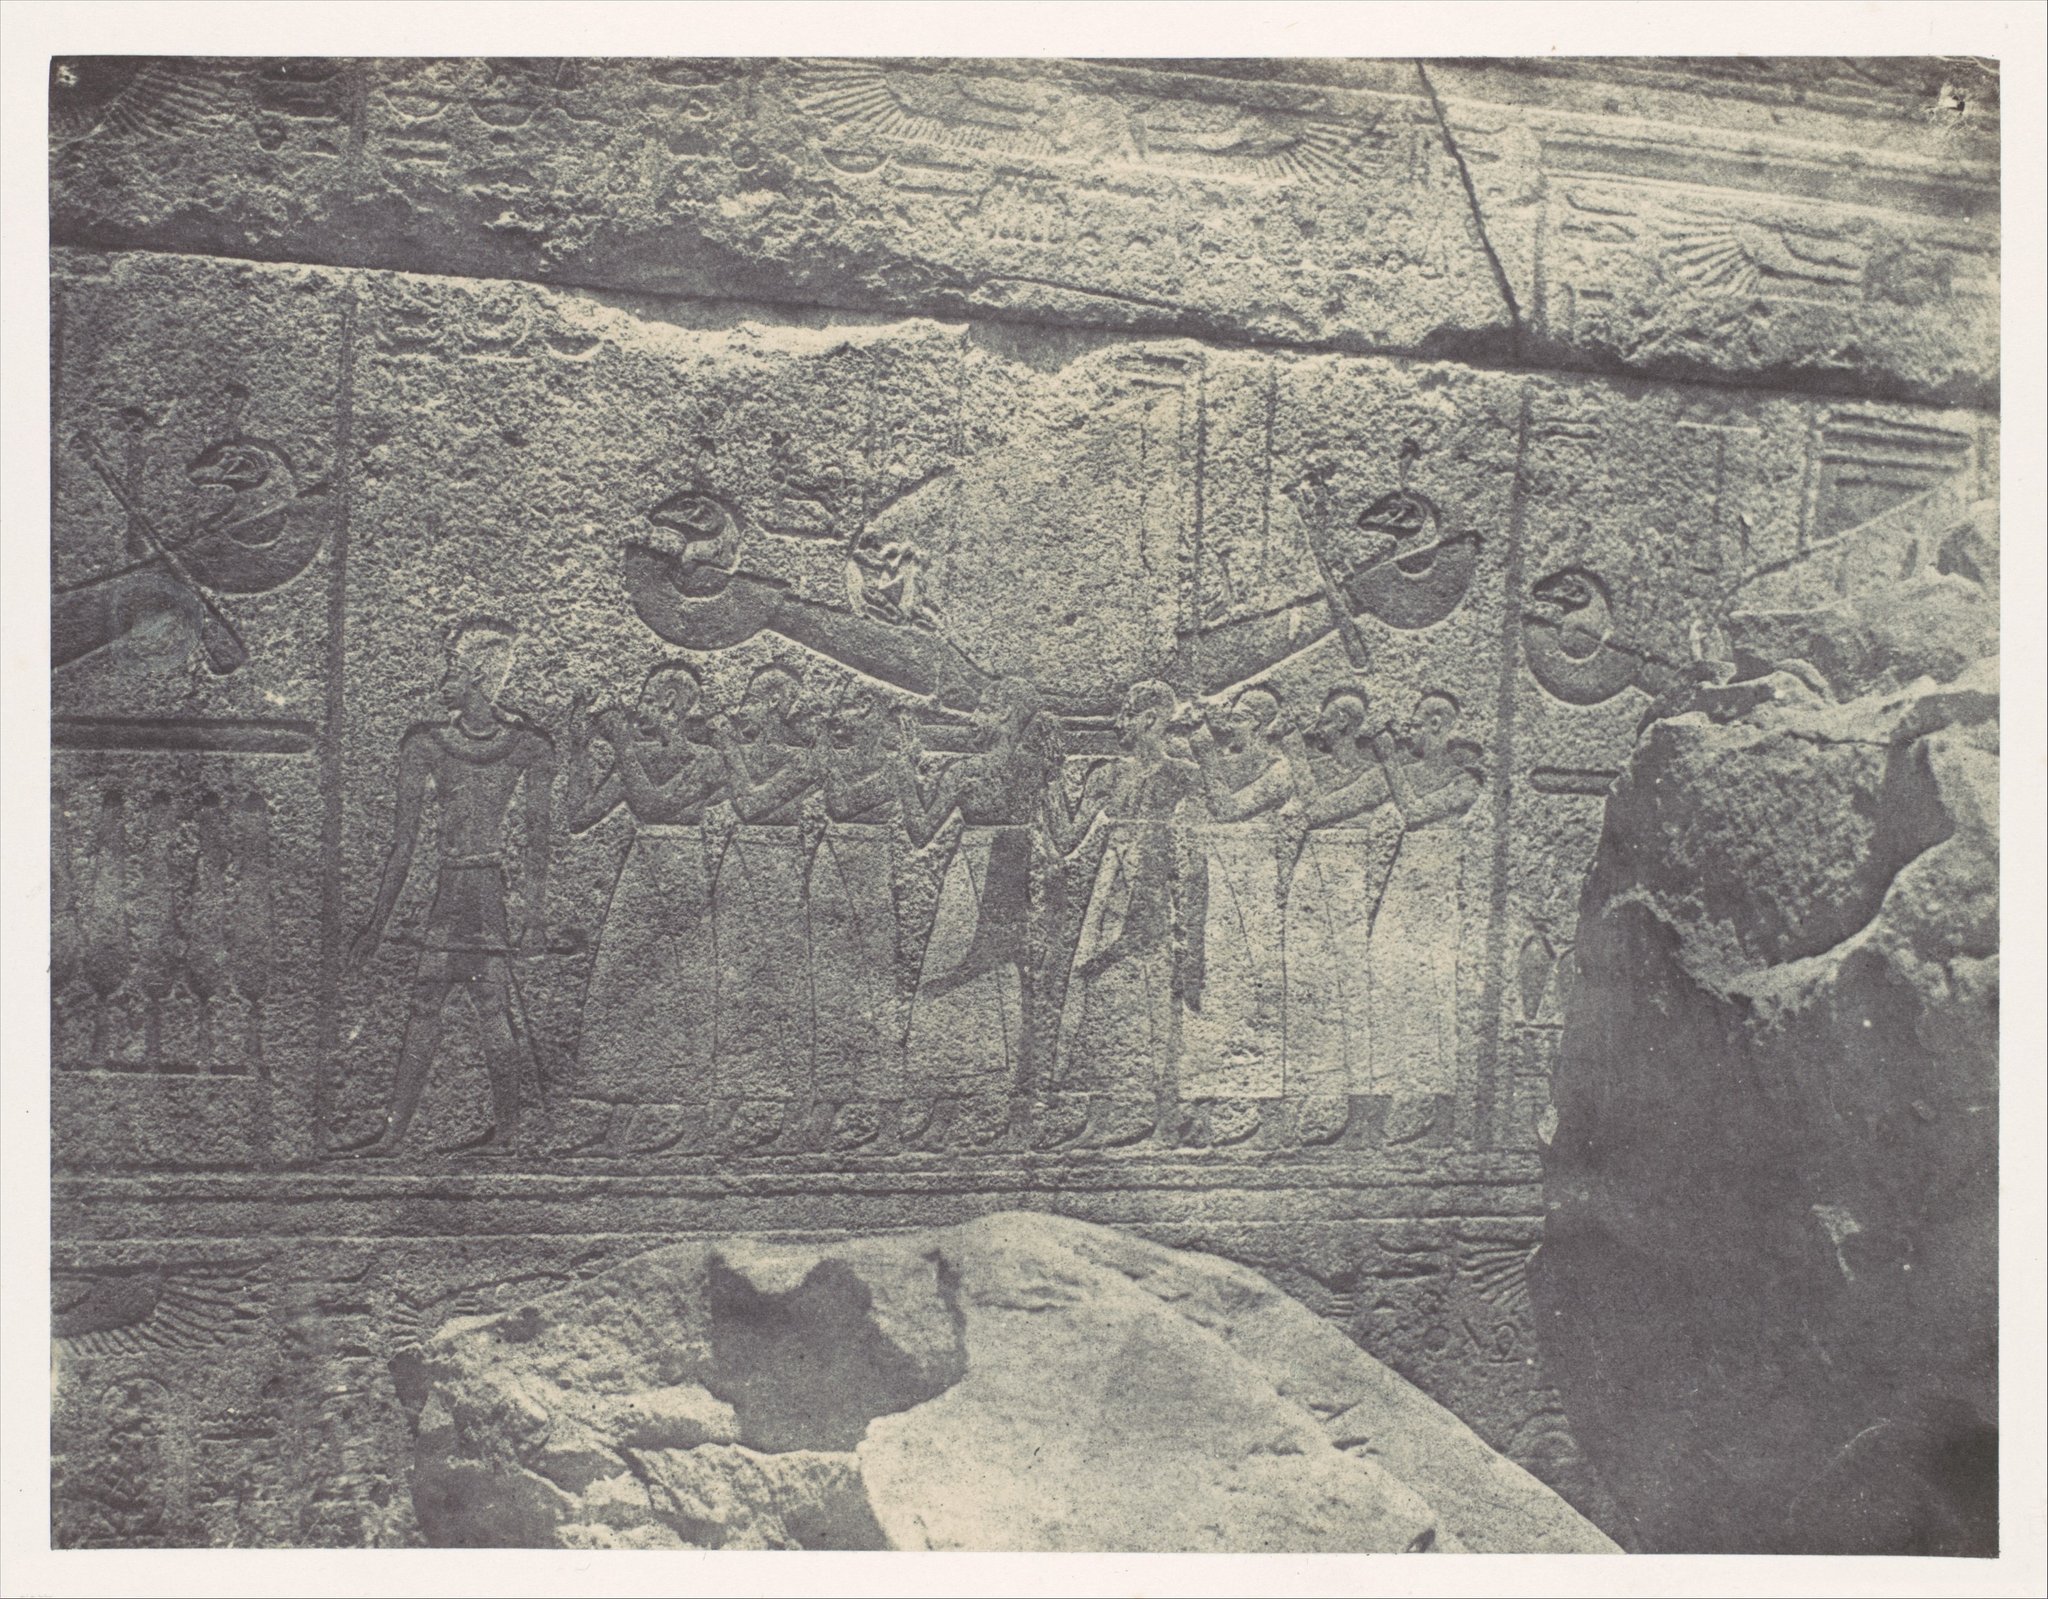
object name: photograph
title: Thebes. Palais de Karnak. Sculptures extérieures du Sanctuaire de granit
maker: maxime du camp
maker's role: artist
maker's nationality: french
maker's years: 1822-1894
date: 1850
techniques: paper negative, salted paper print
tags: sculpture